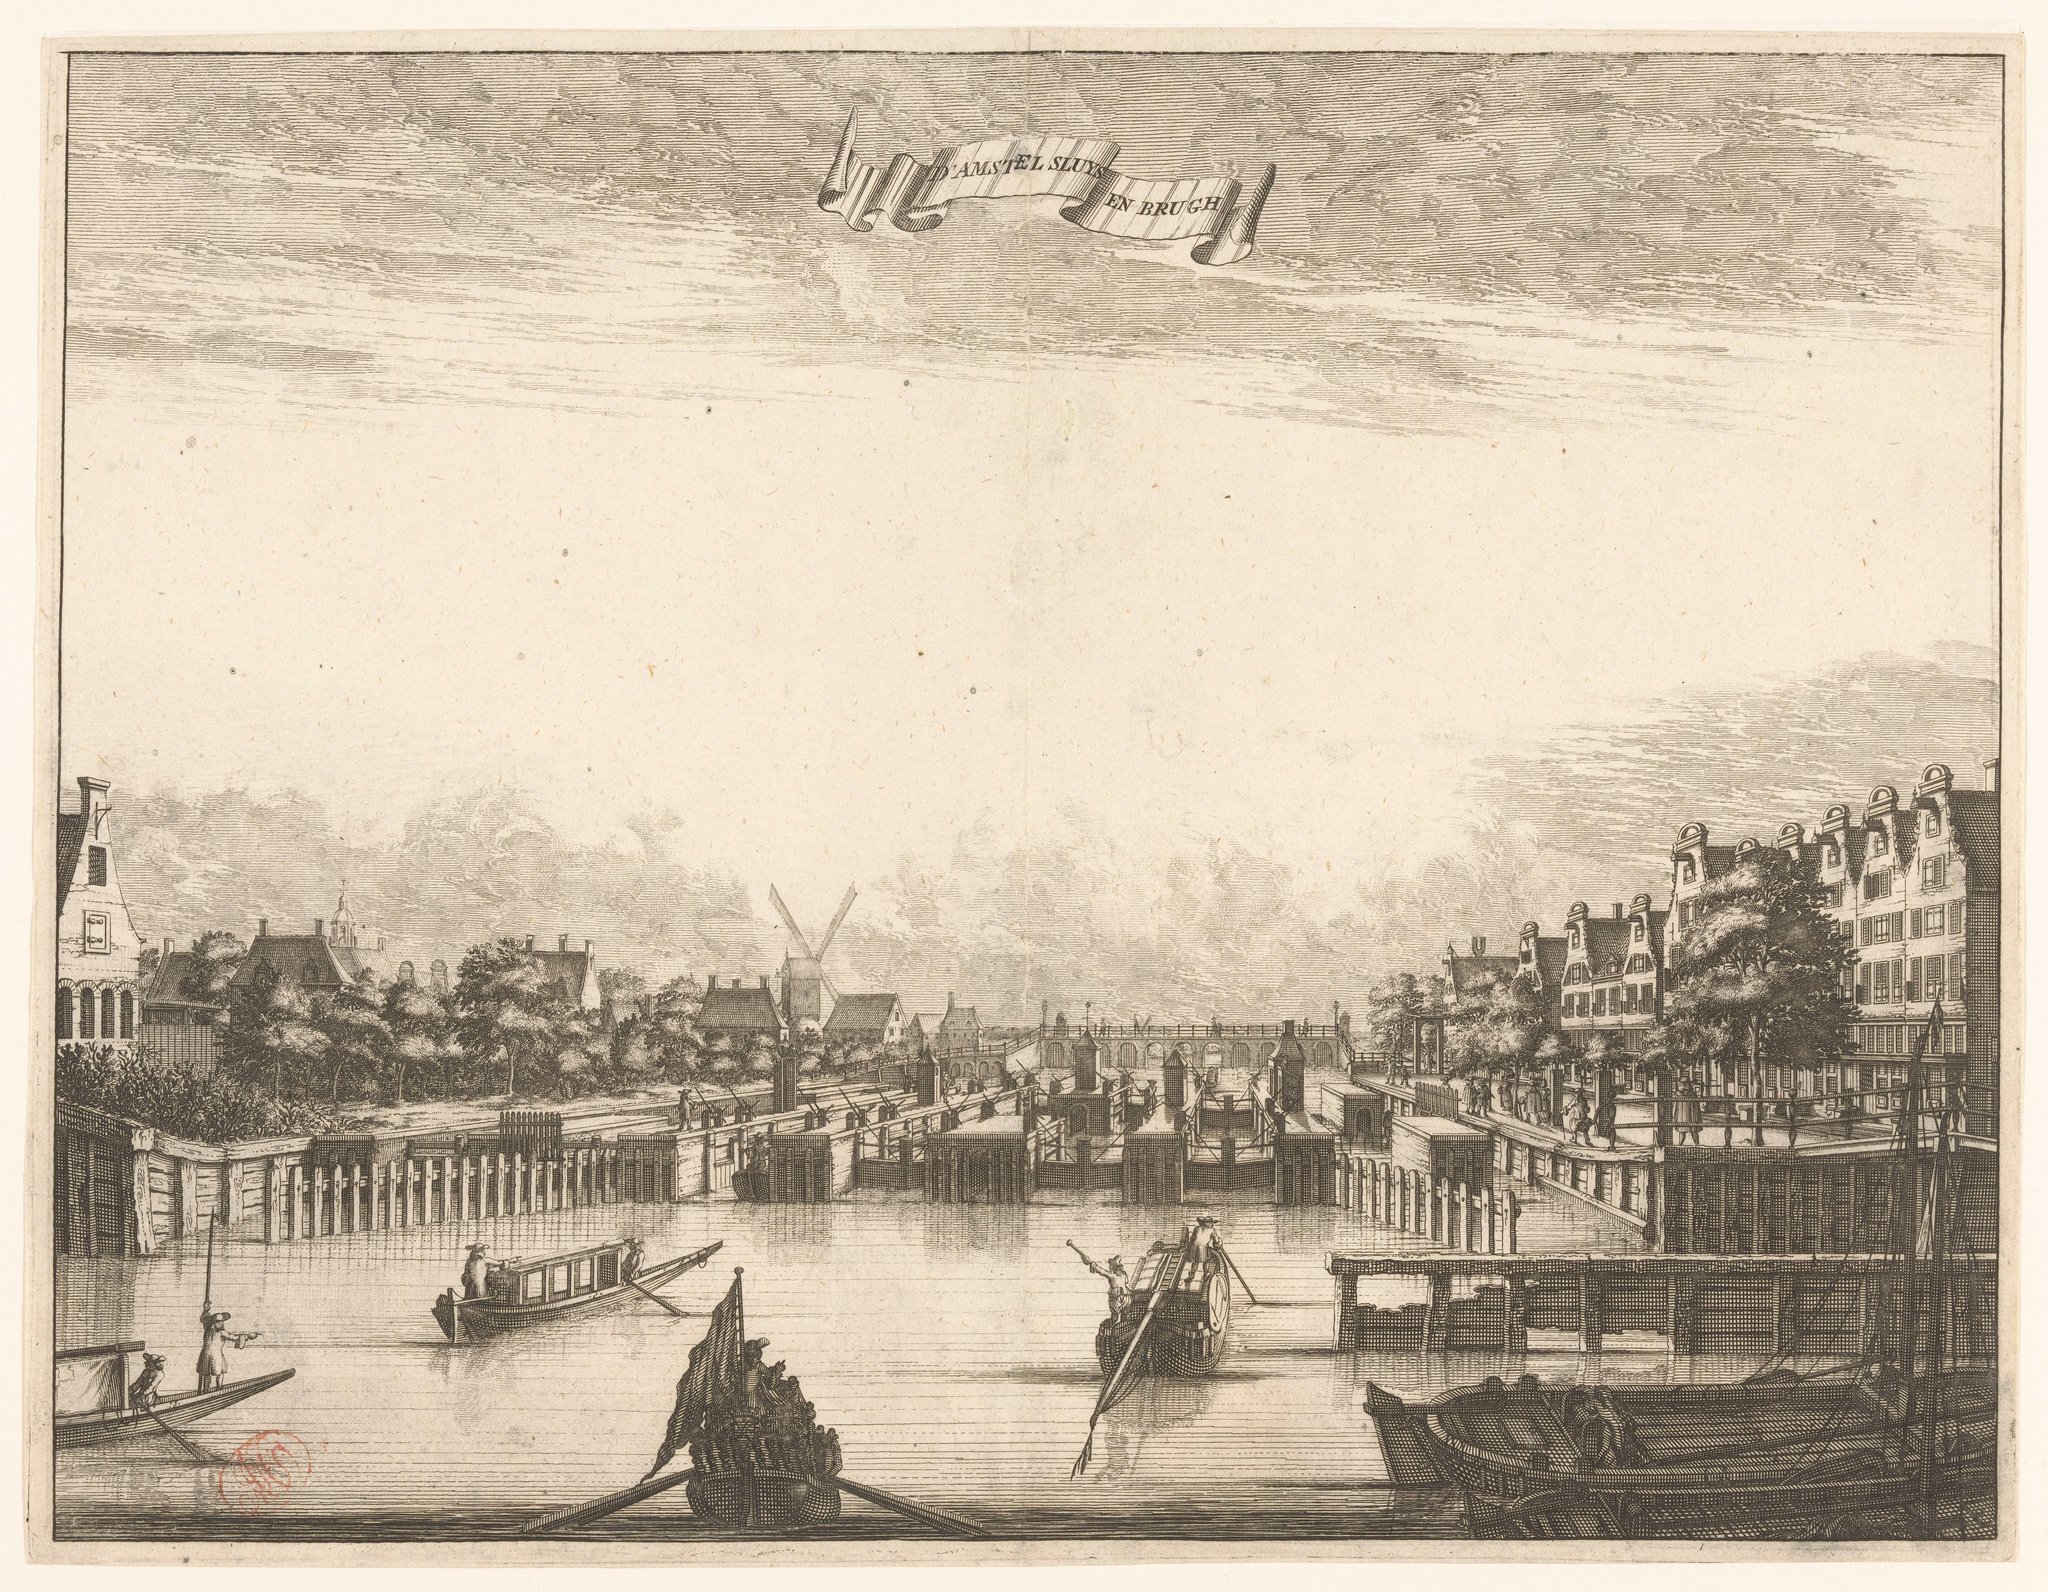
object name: print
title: D'Amstel Sluys en Brugh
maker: Anonymous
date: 1693-1694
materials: paper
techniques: engraving, etching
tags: sluice, weir, bridge in city across river, canal, etc. (+ city(-scape) with figures, staffage), city-gate, canals, waters (in city) (+ city(-scape) with figures, staffage), street (+ city(-scape) with figures, staffage)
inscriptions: collector's mark: Lugt 195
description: Huidige staat van prent ook gebruikt in: Commelin, Caspar. Beschryvinge van Amsterdam, desselfs eerste oorspronk uyt den Huyse (…). 2 delen. Amsterdam: Abraham Wolfgang, Gillis Janssonius van Waesberge, Johannes Janssonius van Waesberge II, weduwe Dirk Boom I, Hendrick Boom en Rembertus Goethals, 1693. En in: Commelin, Caspar. Beschryvinge van Amsterdam, zynde een naukeurige verhandelinge van desselfs eerste oorspronk uyt (…). 2 delen. Amsterdam: weduwe Aart Dircksz Oossaan, 1694. Latere staat ook gebruikt in: Commelin, Caspar. Beschryvinge van Amsterdam, zynde een naukeurige verhandelinge van desselfs eerste oorspronk uyt (…). 2 delen. 2e druk. Amsterdam: Andries van Damme, Johannes Ratelband, weduwe A. van Aaltwyk en Hermanus Uytwerf, 1726.